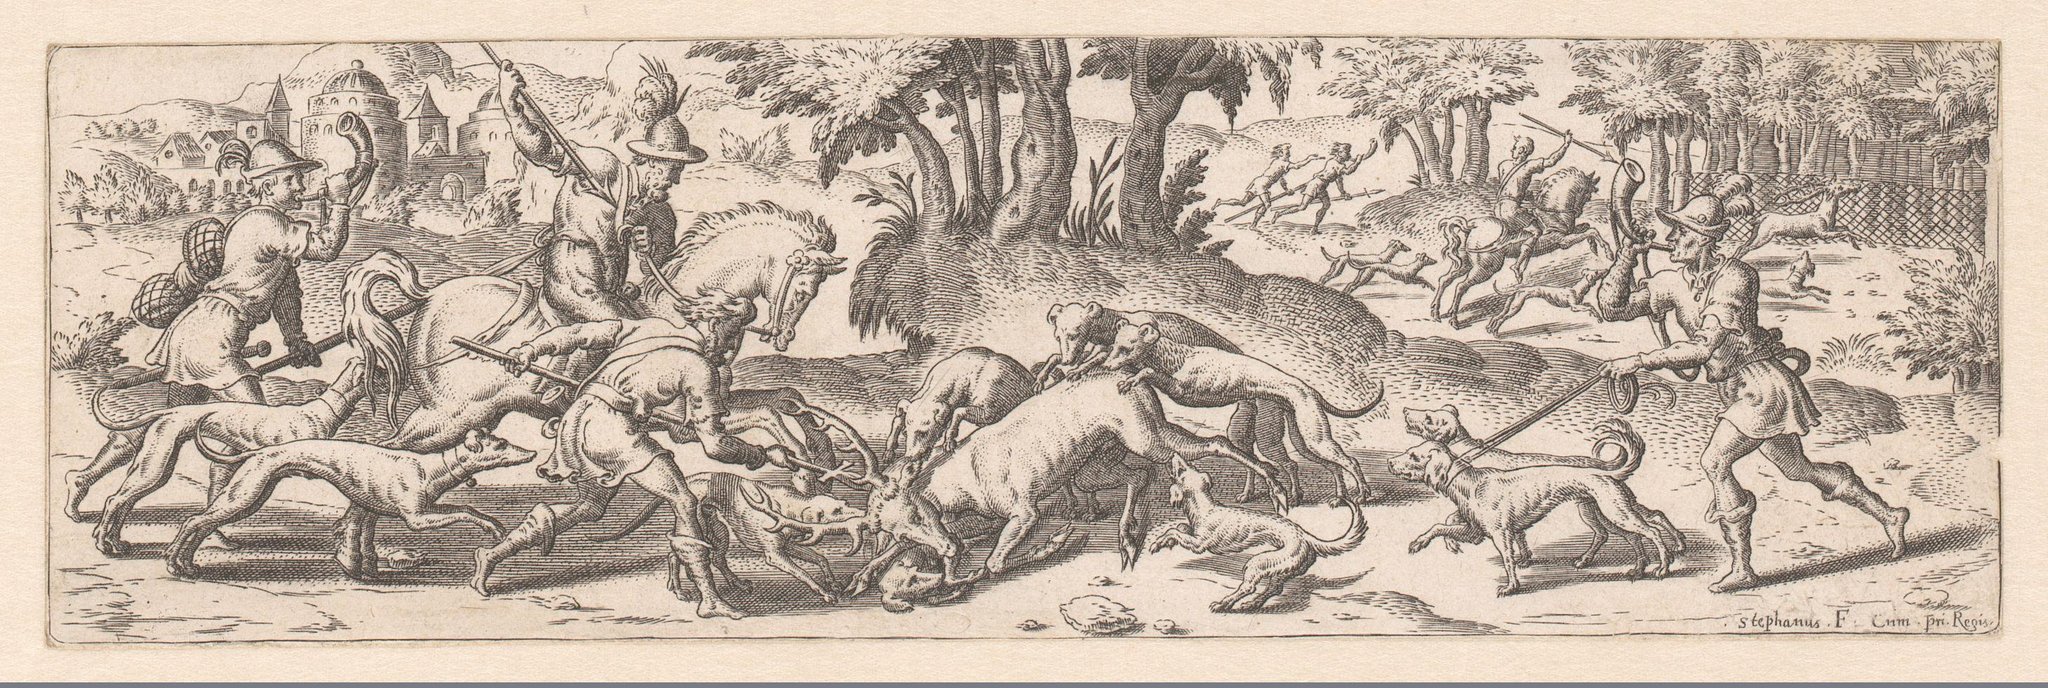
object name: print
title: Chasses a différents animaux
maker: etienne delaune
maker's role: draughtsman, goldsmith, print maker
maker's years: 1519-1583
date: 1528-1583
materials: paper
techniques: engraving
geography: france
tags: stag-hunting, hunting dogs, hoofed animals: stag, hunters hunting (n.b.: in 1988-1990 this notation denoted the concept of 43c11421 'hunters resting during the hunt')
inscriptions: collector's mark: Lugt 2228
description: Maakt deel uit van een zesdelige serie met jachtscènes in friesvorm.